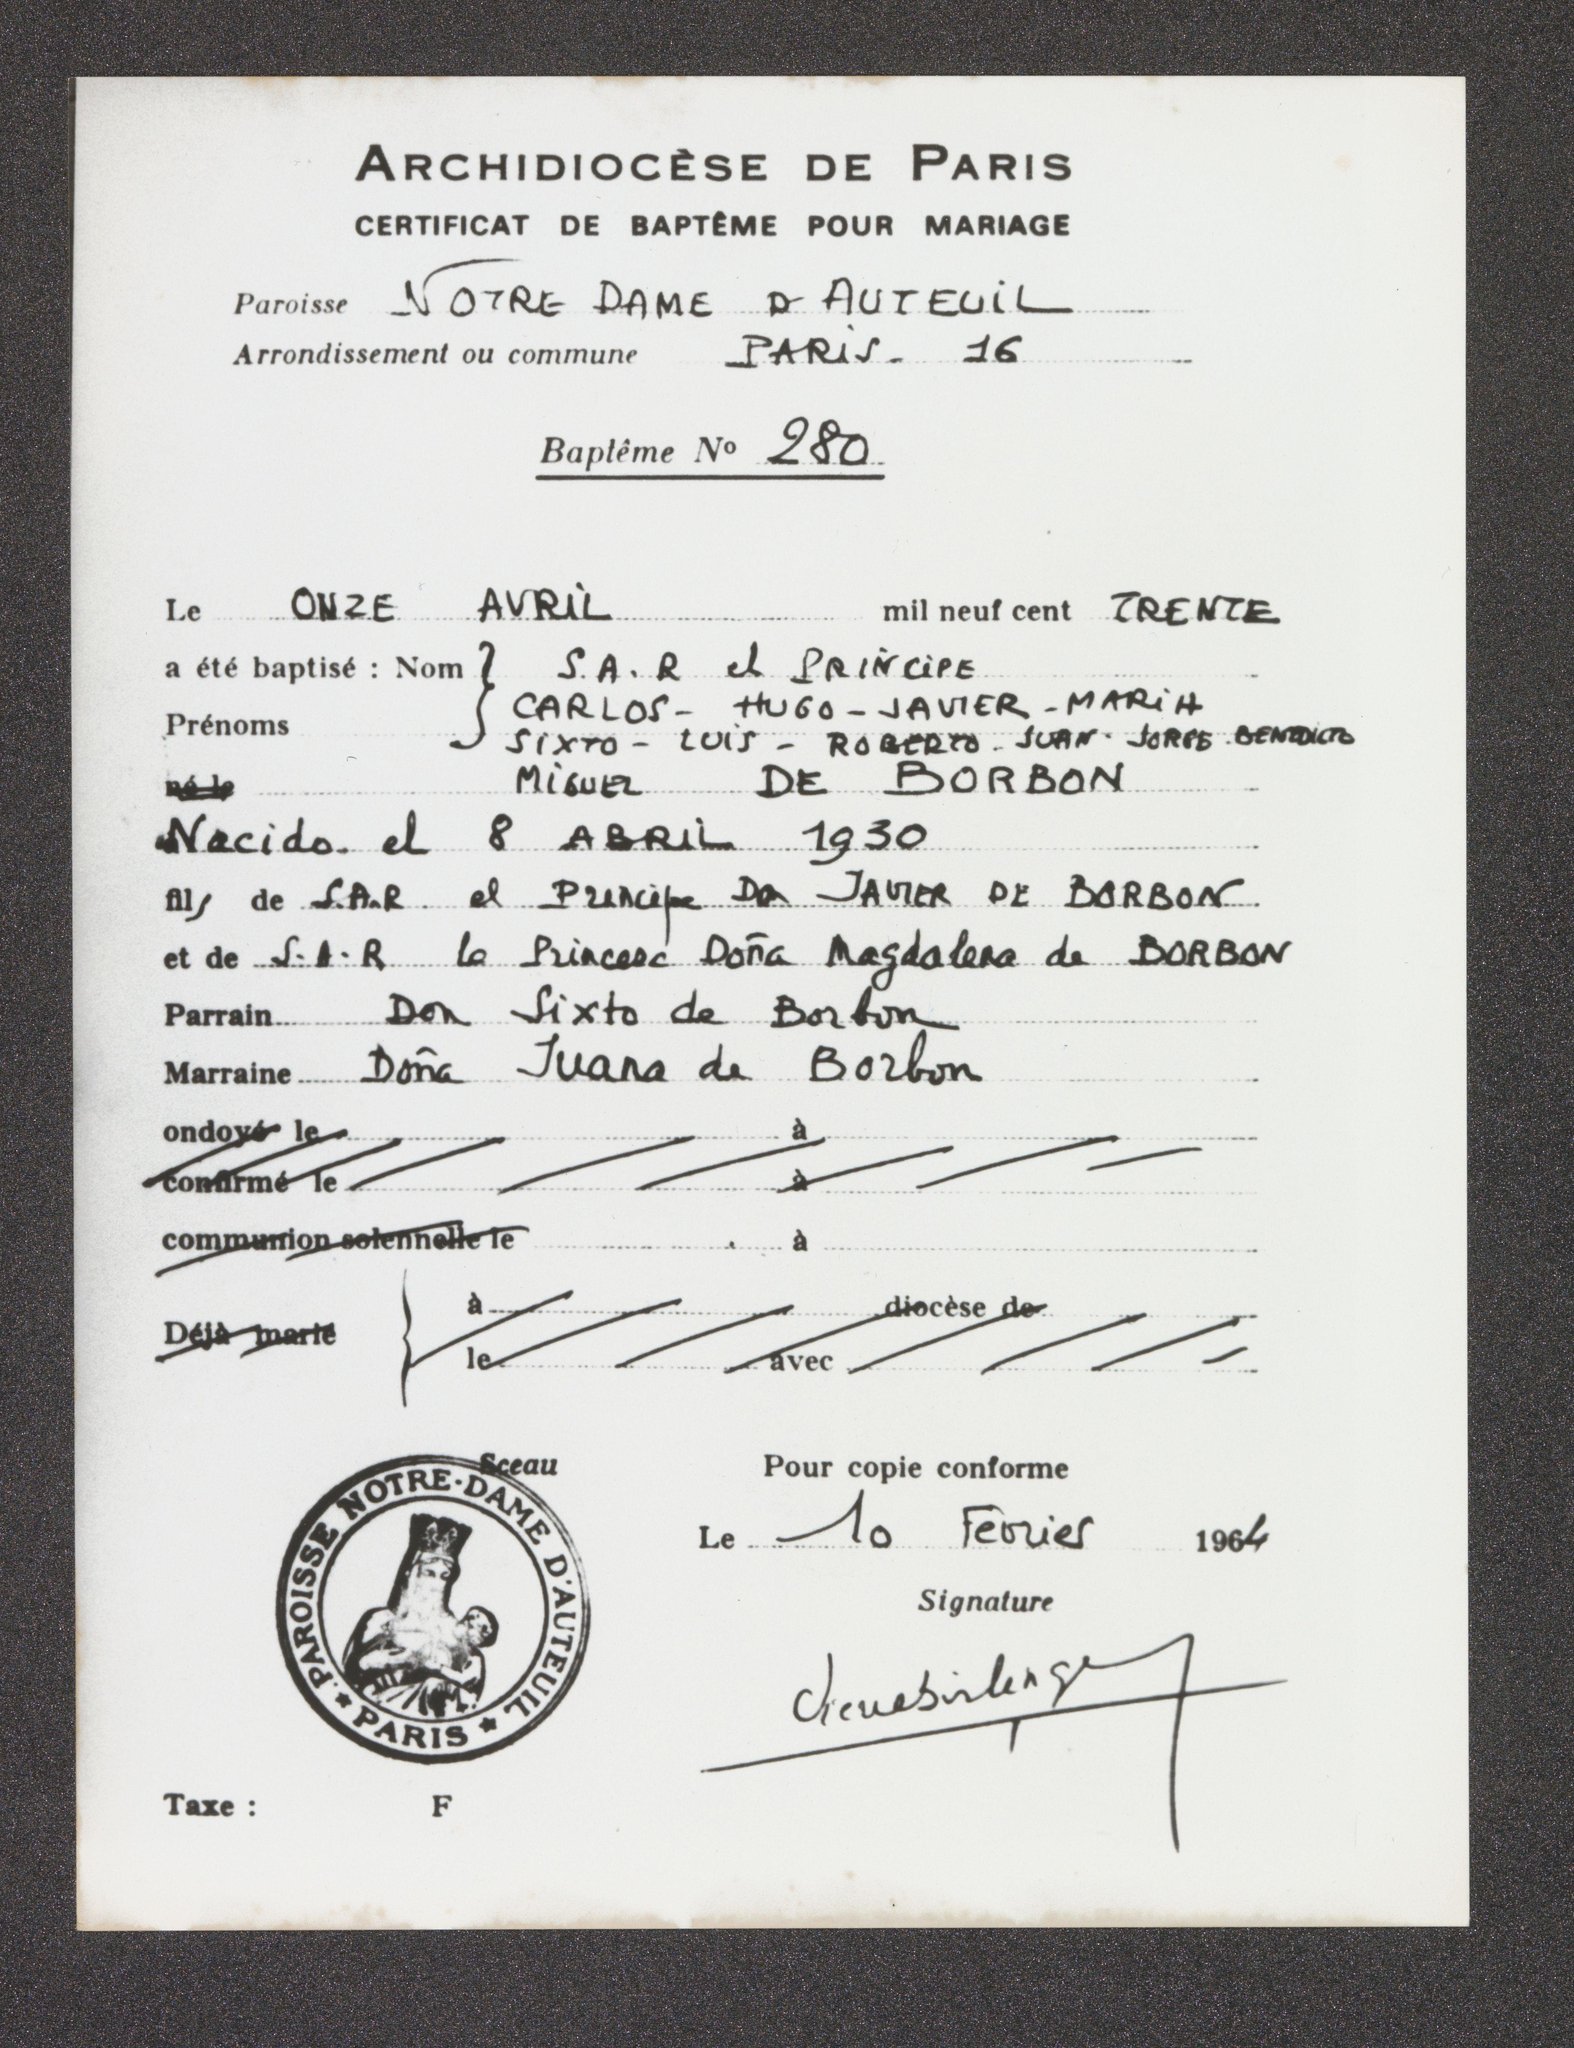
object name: photograph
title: Doopcertificaat van Carlos Hugo Bourbon de Parma uitgegeven in Parijs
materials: paper, photographic support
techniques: gelatin silver print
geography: amsterdam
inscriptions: stamp: ‘copyright ANEFO Achtergracht 17 Amsterdam C’